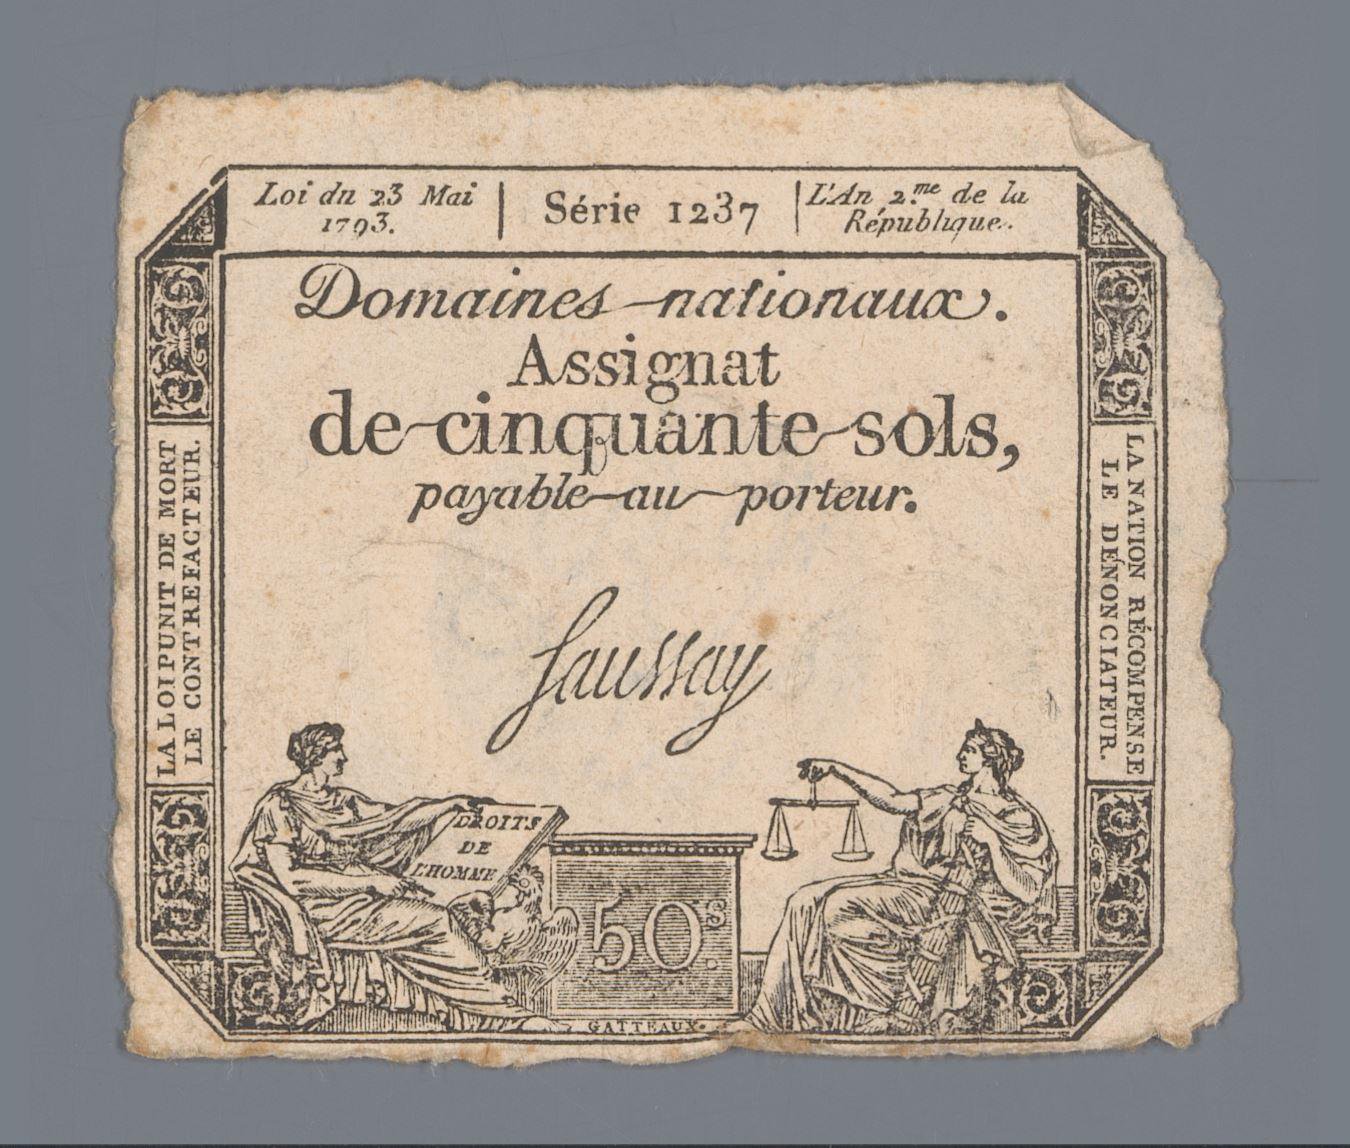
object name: assignat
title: Assignat van vijftig sols, serie 1237 uitgegeven 23 mei 1793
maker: nicolas marie gatteaux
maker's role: medailleur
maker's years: 1751-1832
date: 1793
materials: paper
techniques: printing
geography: france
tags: france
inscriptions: date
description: Franse assignaat à 50 sols, uit serie 1237, getekend door Faussay, éénzijdig bedrukt. Gesigneerd en gedateerd. Gemerkt: twee reliëfstempels.